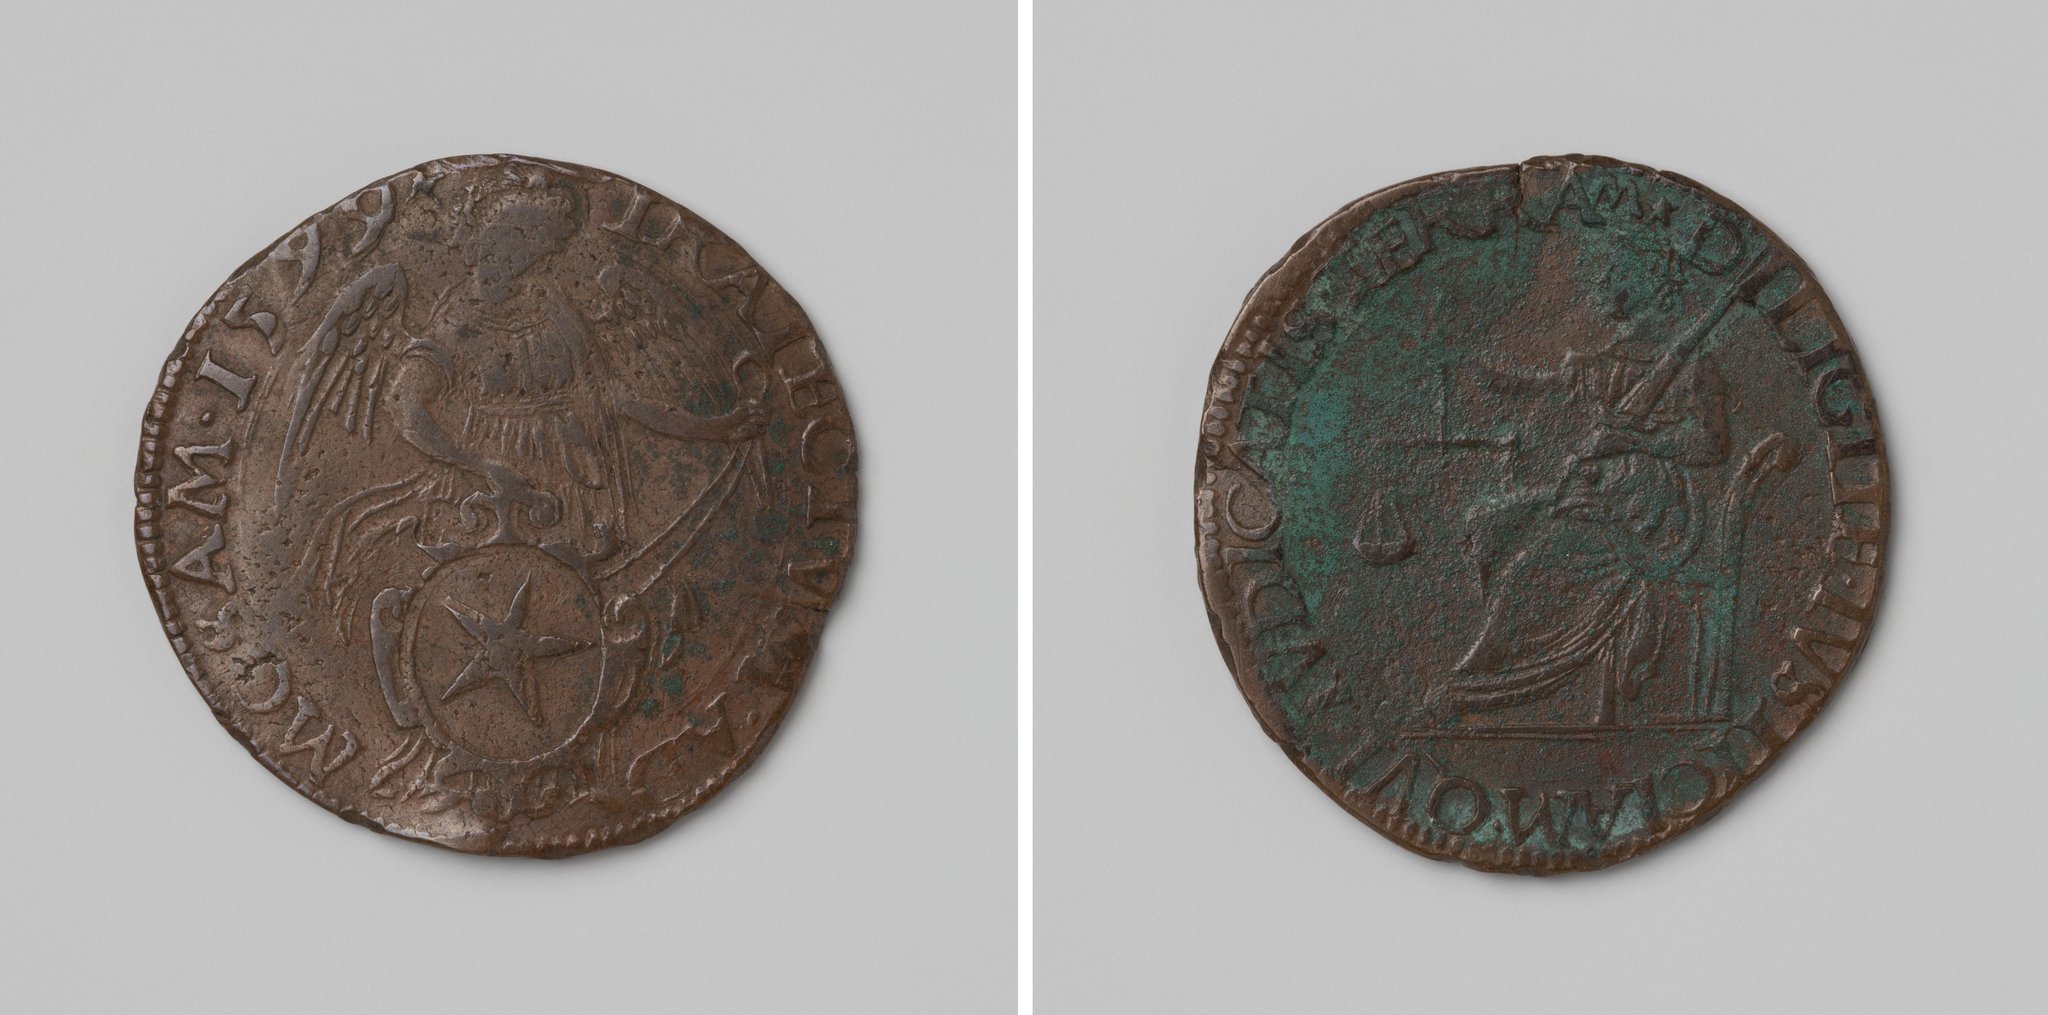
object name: jeton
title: Stad Maastricht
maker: Anonymous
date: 1599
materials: copper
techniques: striking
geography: netherlands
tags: maastricht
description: Koperen penning. Voorzijde: engel houdt wapenschild in cartouche voor zich binnen omschrift. Keerzijde: zittende vrouw met weegschaal en zwaard, voorstellende Gerechtigheid binnen omschrift